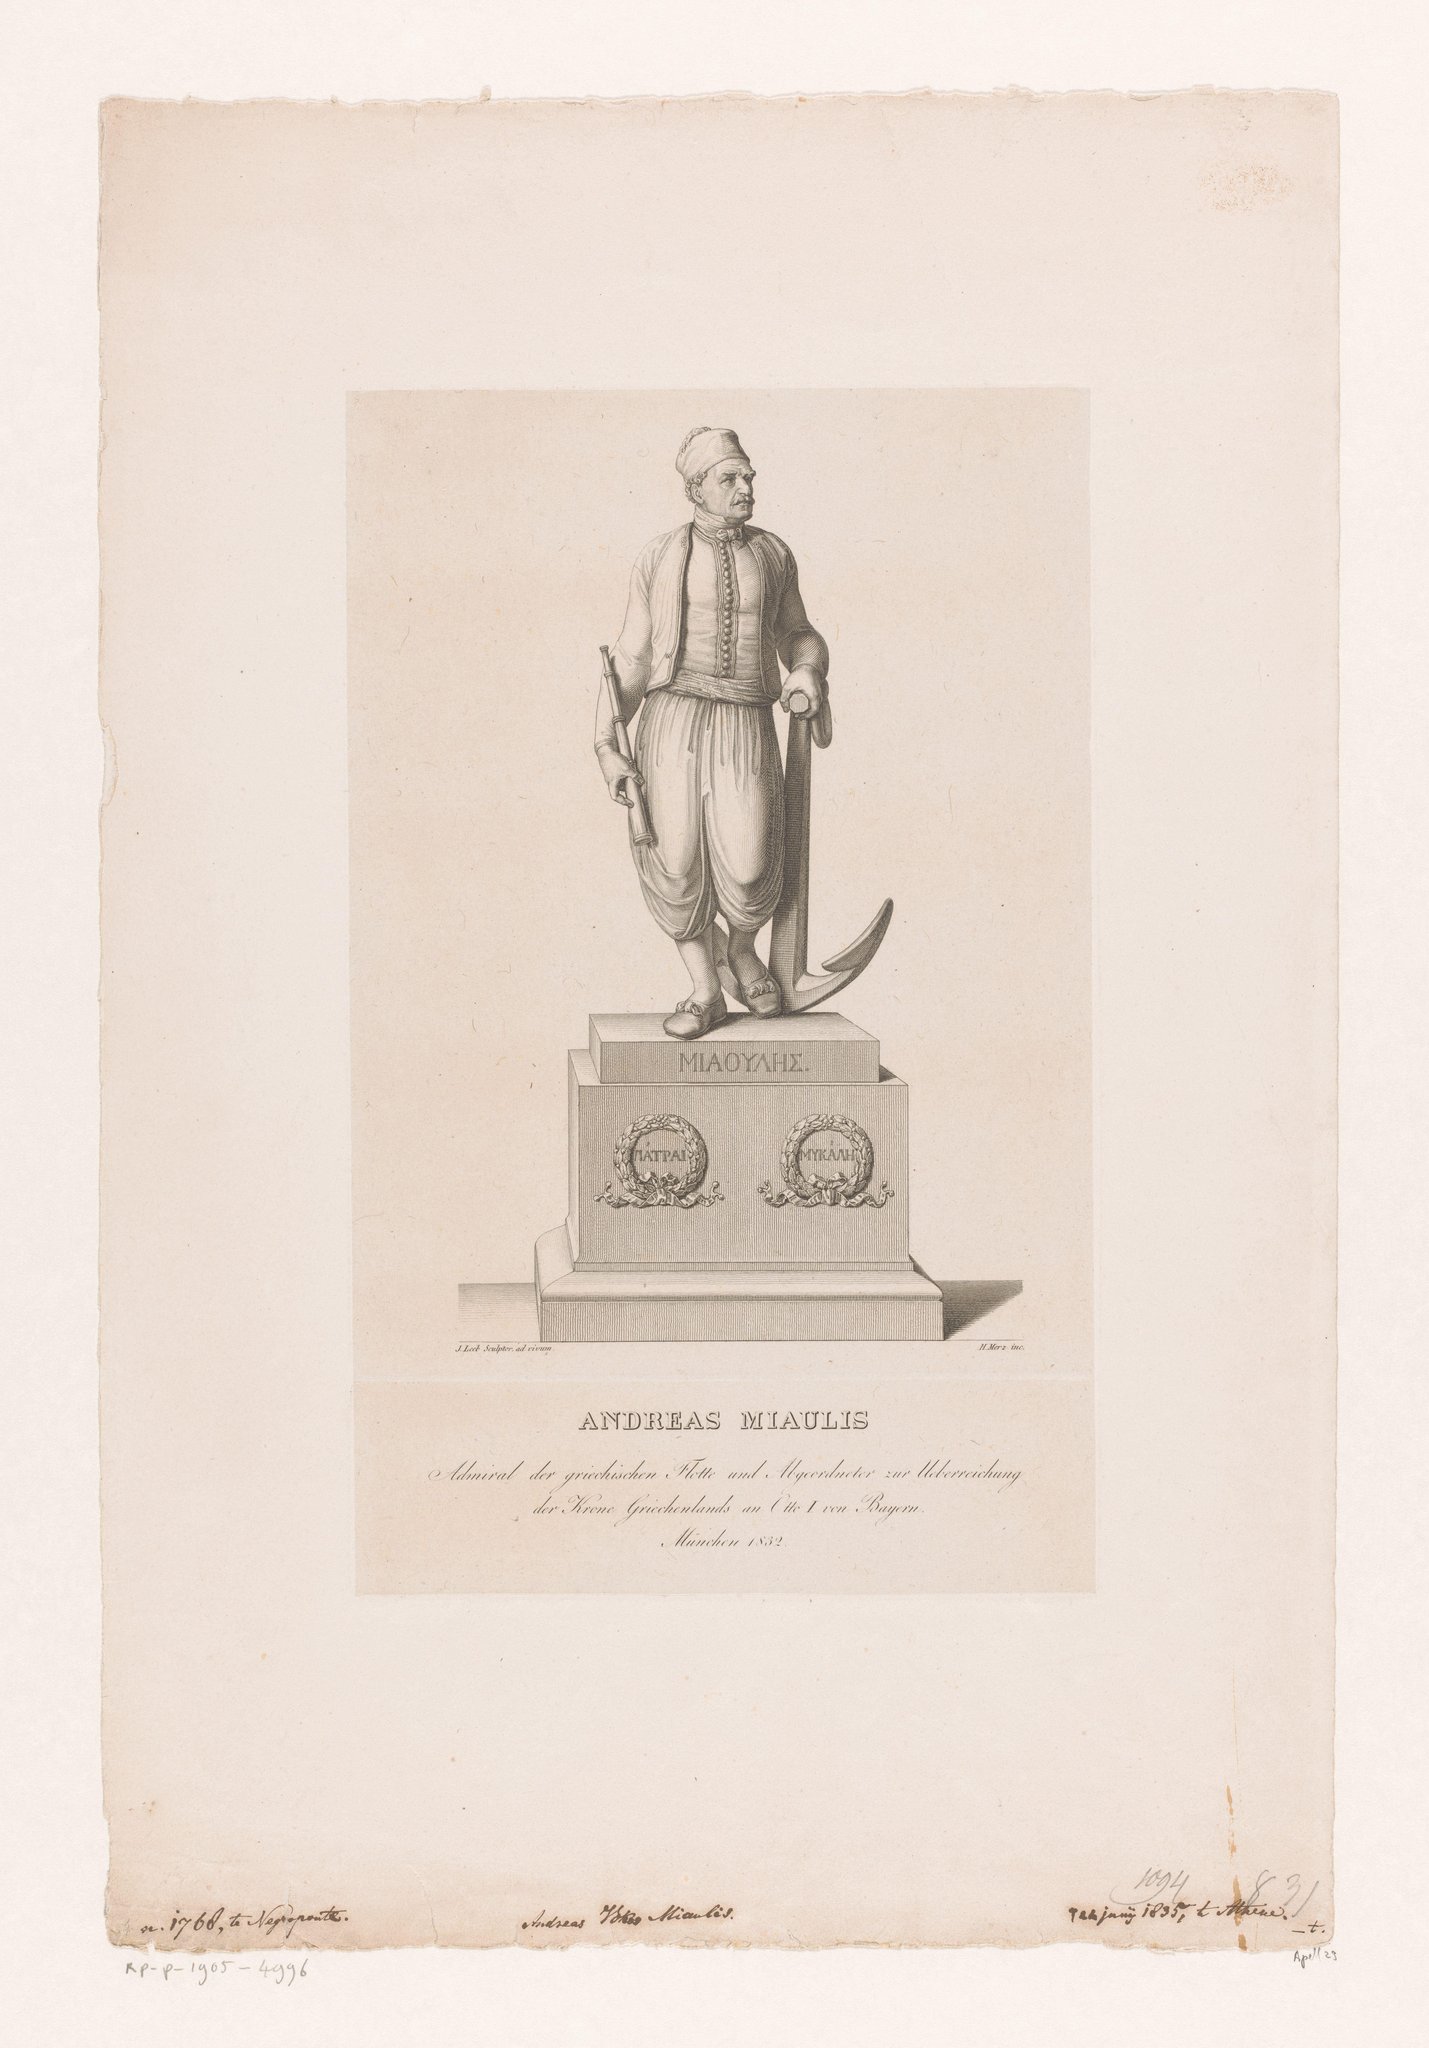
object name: print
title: Standbeeld van Andreas Miaulis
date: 1832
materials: paper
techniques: engraving, etching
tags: politician, monument, statue, commander-in-chief, admiral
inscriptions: collector's mark: Lugt 2228